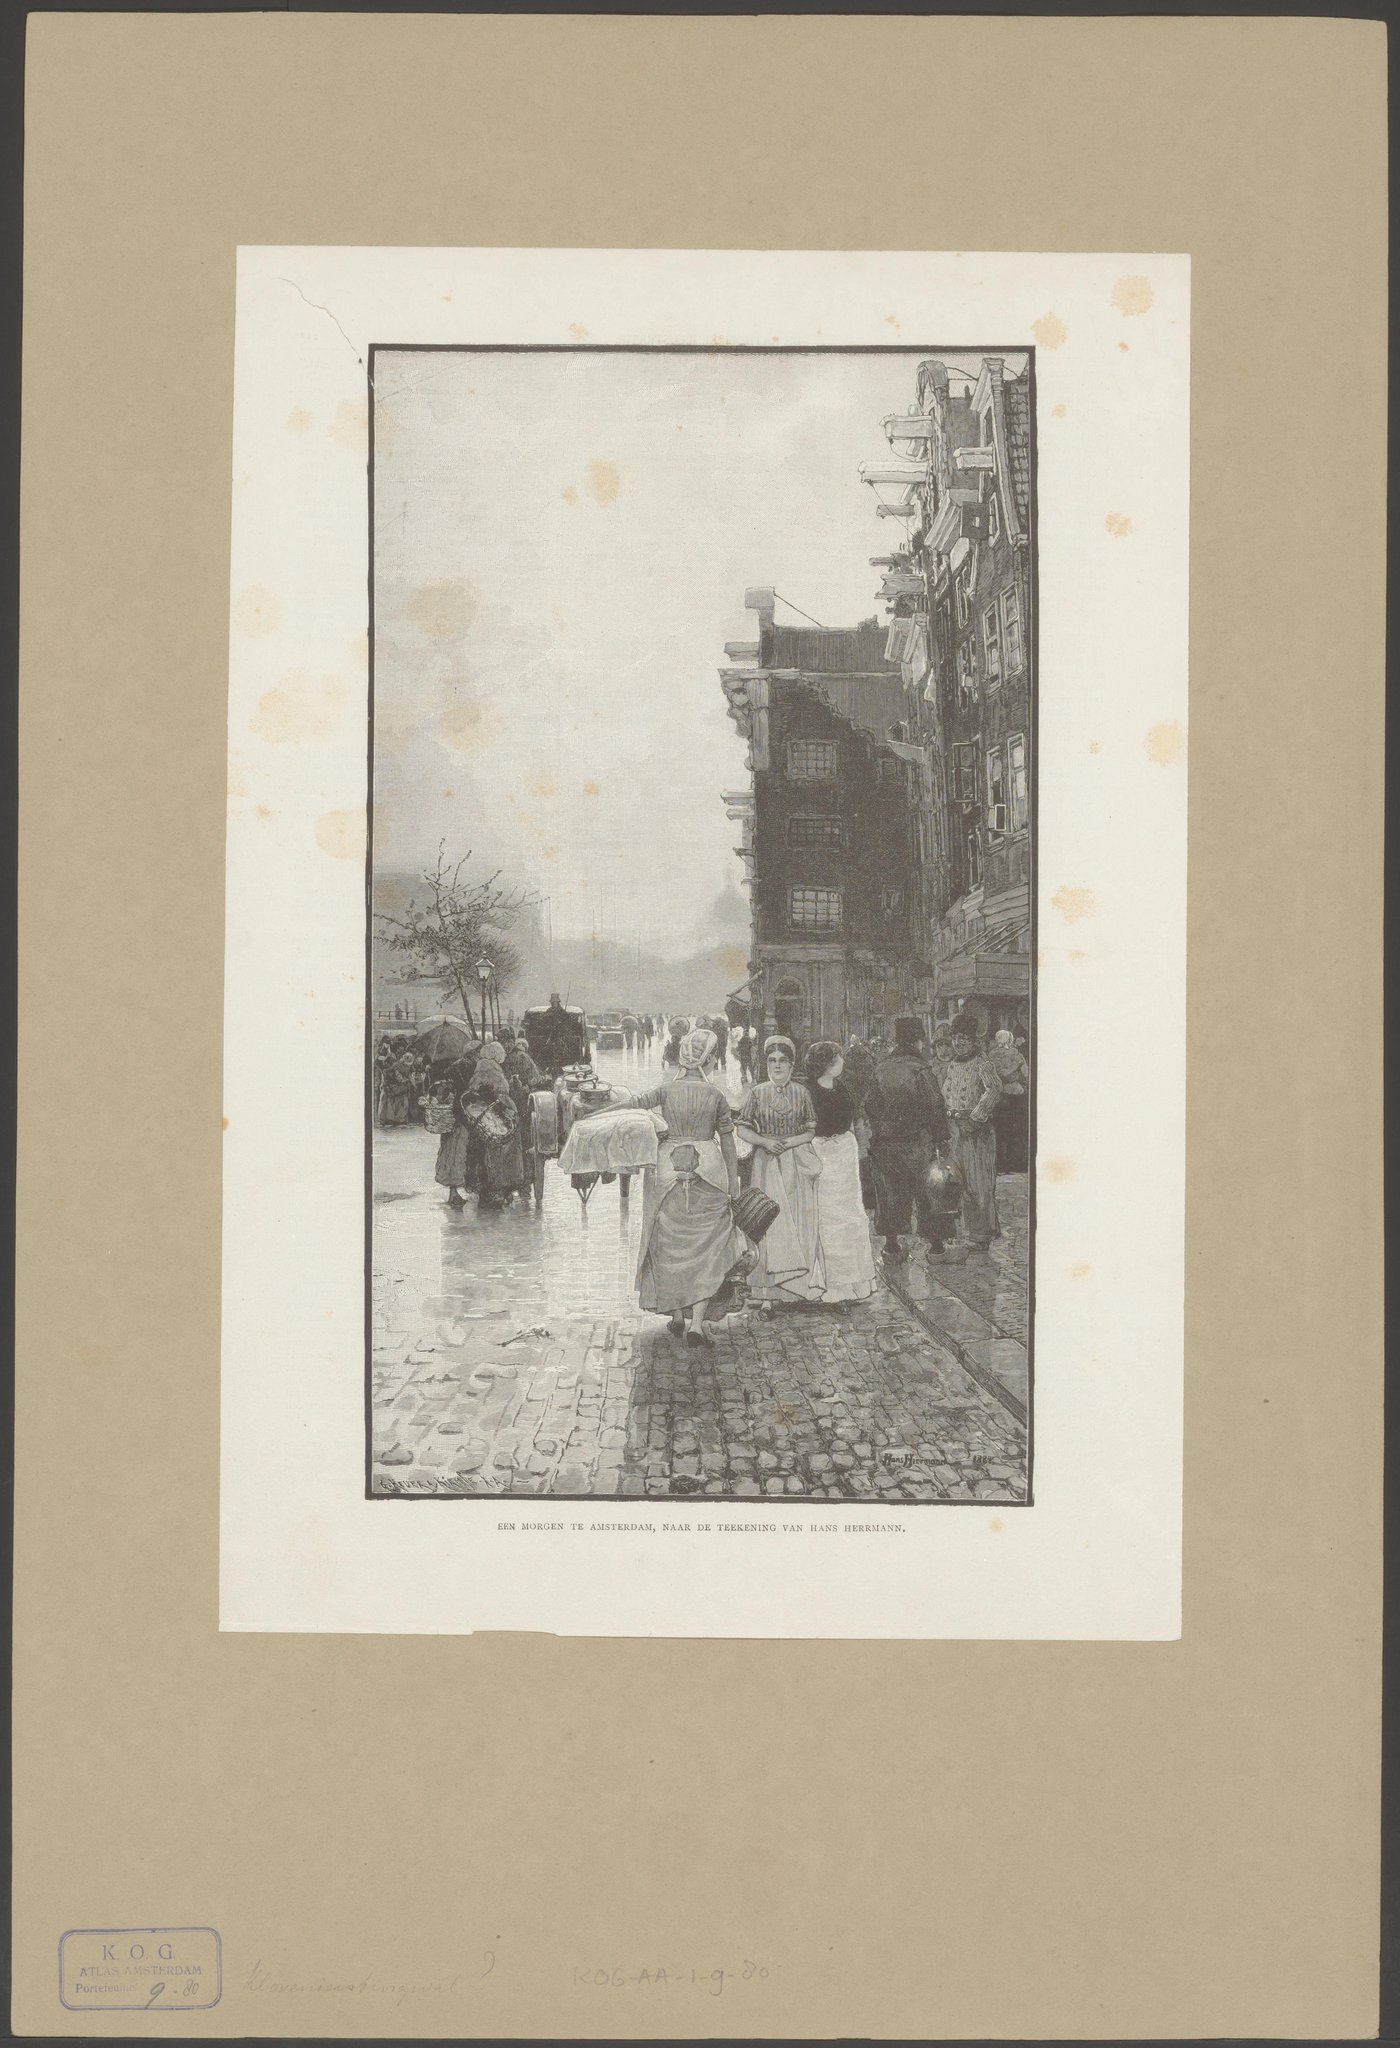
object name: print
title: Gezicht op een straat in Amsterdam, mogelijk de Kloveniersburgwal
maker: hans herrmann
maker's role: painter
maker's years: 1858-1942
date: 1868-1950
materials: paper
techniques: engraving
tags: city-view in general; 'veduta', the usual house or row of houses, street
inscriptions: collector's mark: ‘9.80’, inscription: ‘Kloveniersburgwal ?’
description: Onderwerpsrubriek binnen de Atlas Amsterdam: Kadijksplein, Karthuizerkerkhof, Kattegat, Kattenburg, Kapelsteeg O.Z., Enge Kerksteeg, Kerkstraat, Kinkerstraat, Kolk O.Z., Koningsplein, Kromboomsloot [Krom Boomssloot], Kostverlorenkade, Kwakersdwarspad, Kalverstraat, Keizersgracht (v.d. Brouwersgracht – Amstel), Klerensloot (Gedempte), Klimopstraat, Kloveniersburgwal, Kraansluis.